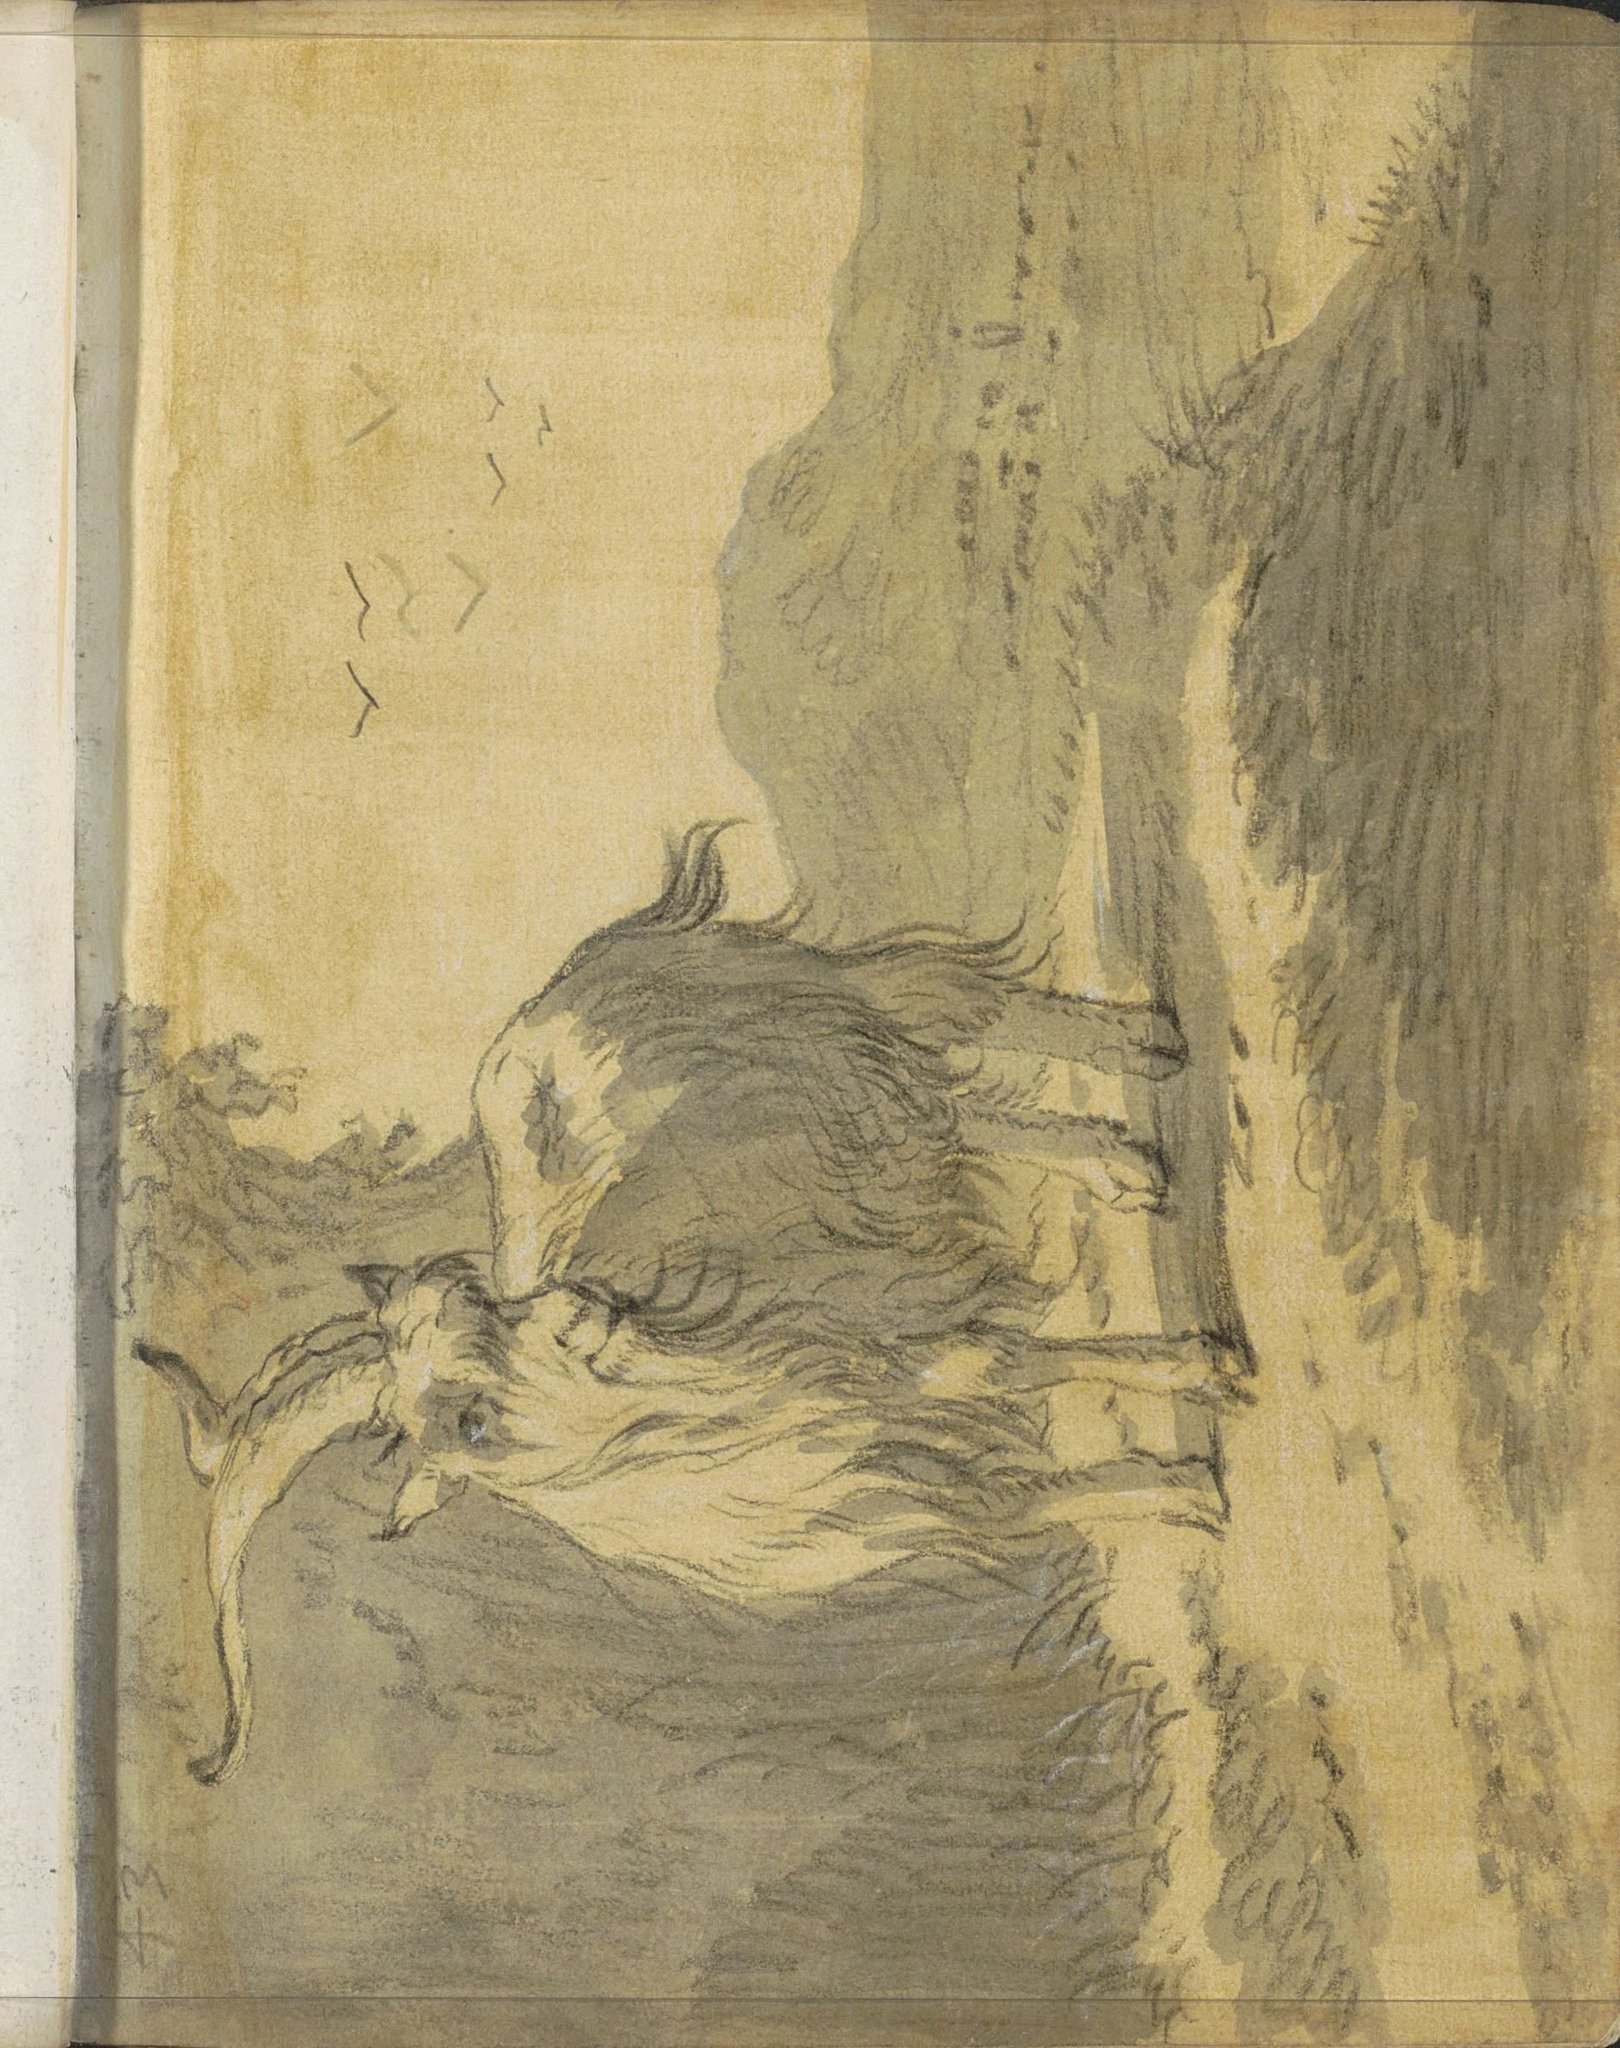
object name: sketchbook leaf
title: Langharige geit in een landschap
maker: cornelis saftleven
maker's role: draughtsman, painter, print maker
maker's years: 1607-1681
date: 1666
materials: chalk, ink, paper, pencil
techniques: brush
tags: landscapes, goat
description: Blad 43 recto uit een schetsboek met 49 bladen.